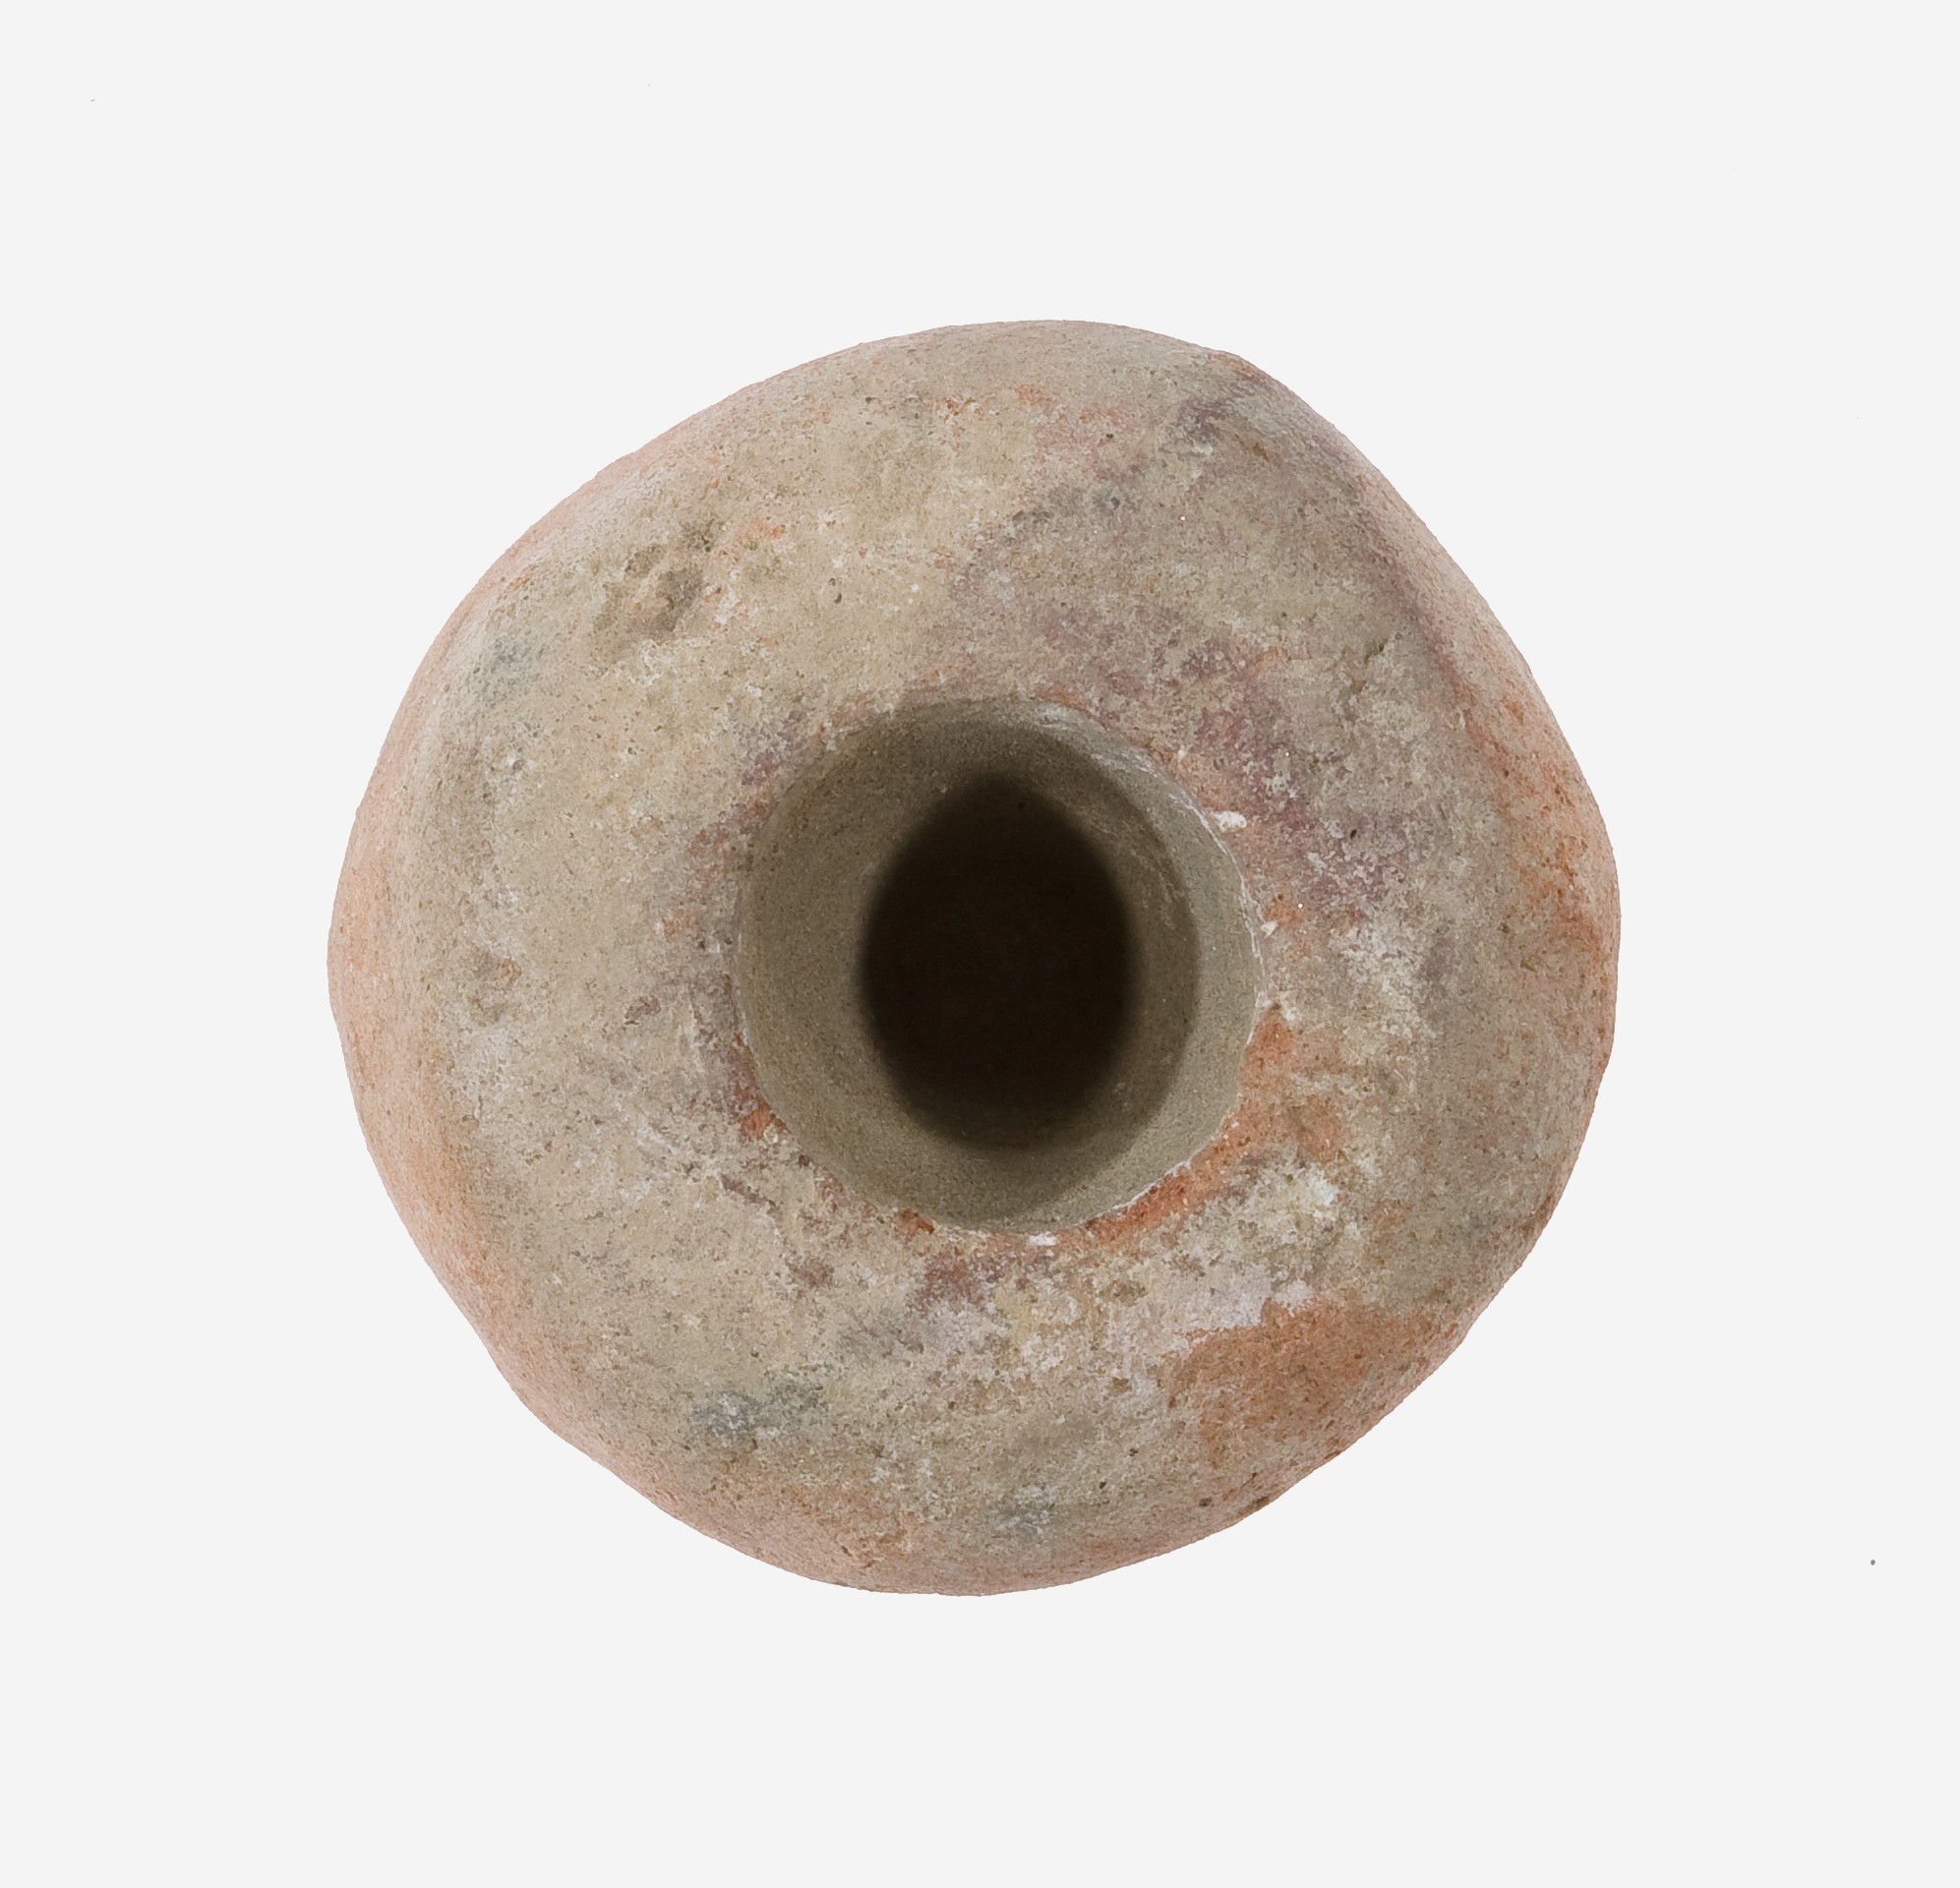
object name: mold, pendant, umbel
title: Mold for Umbel Pendant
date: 1390-1352 BCE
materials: pottery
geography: egypt